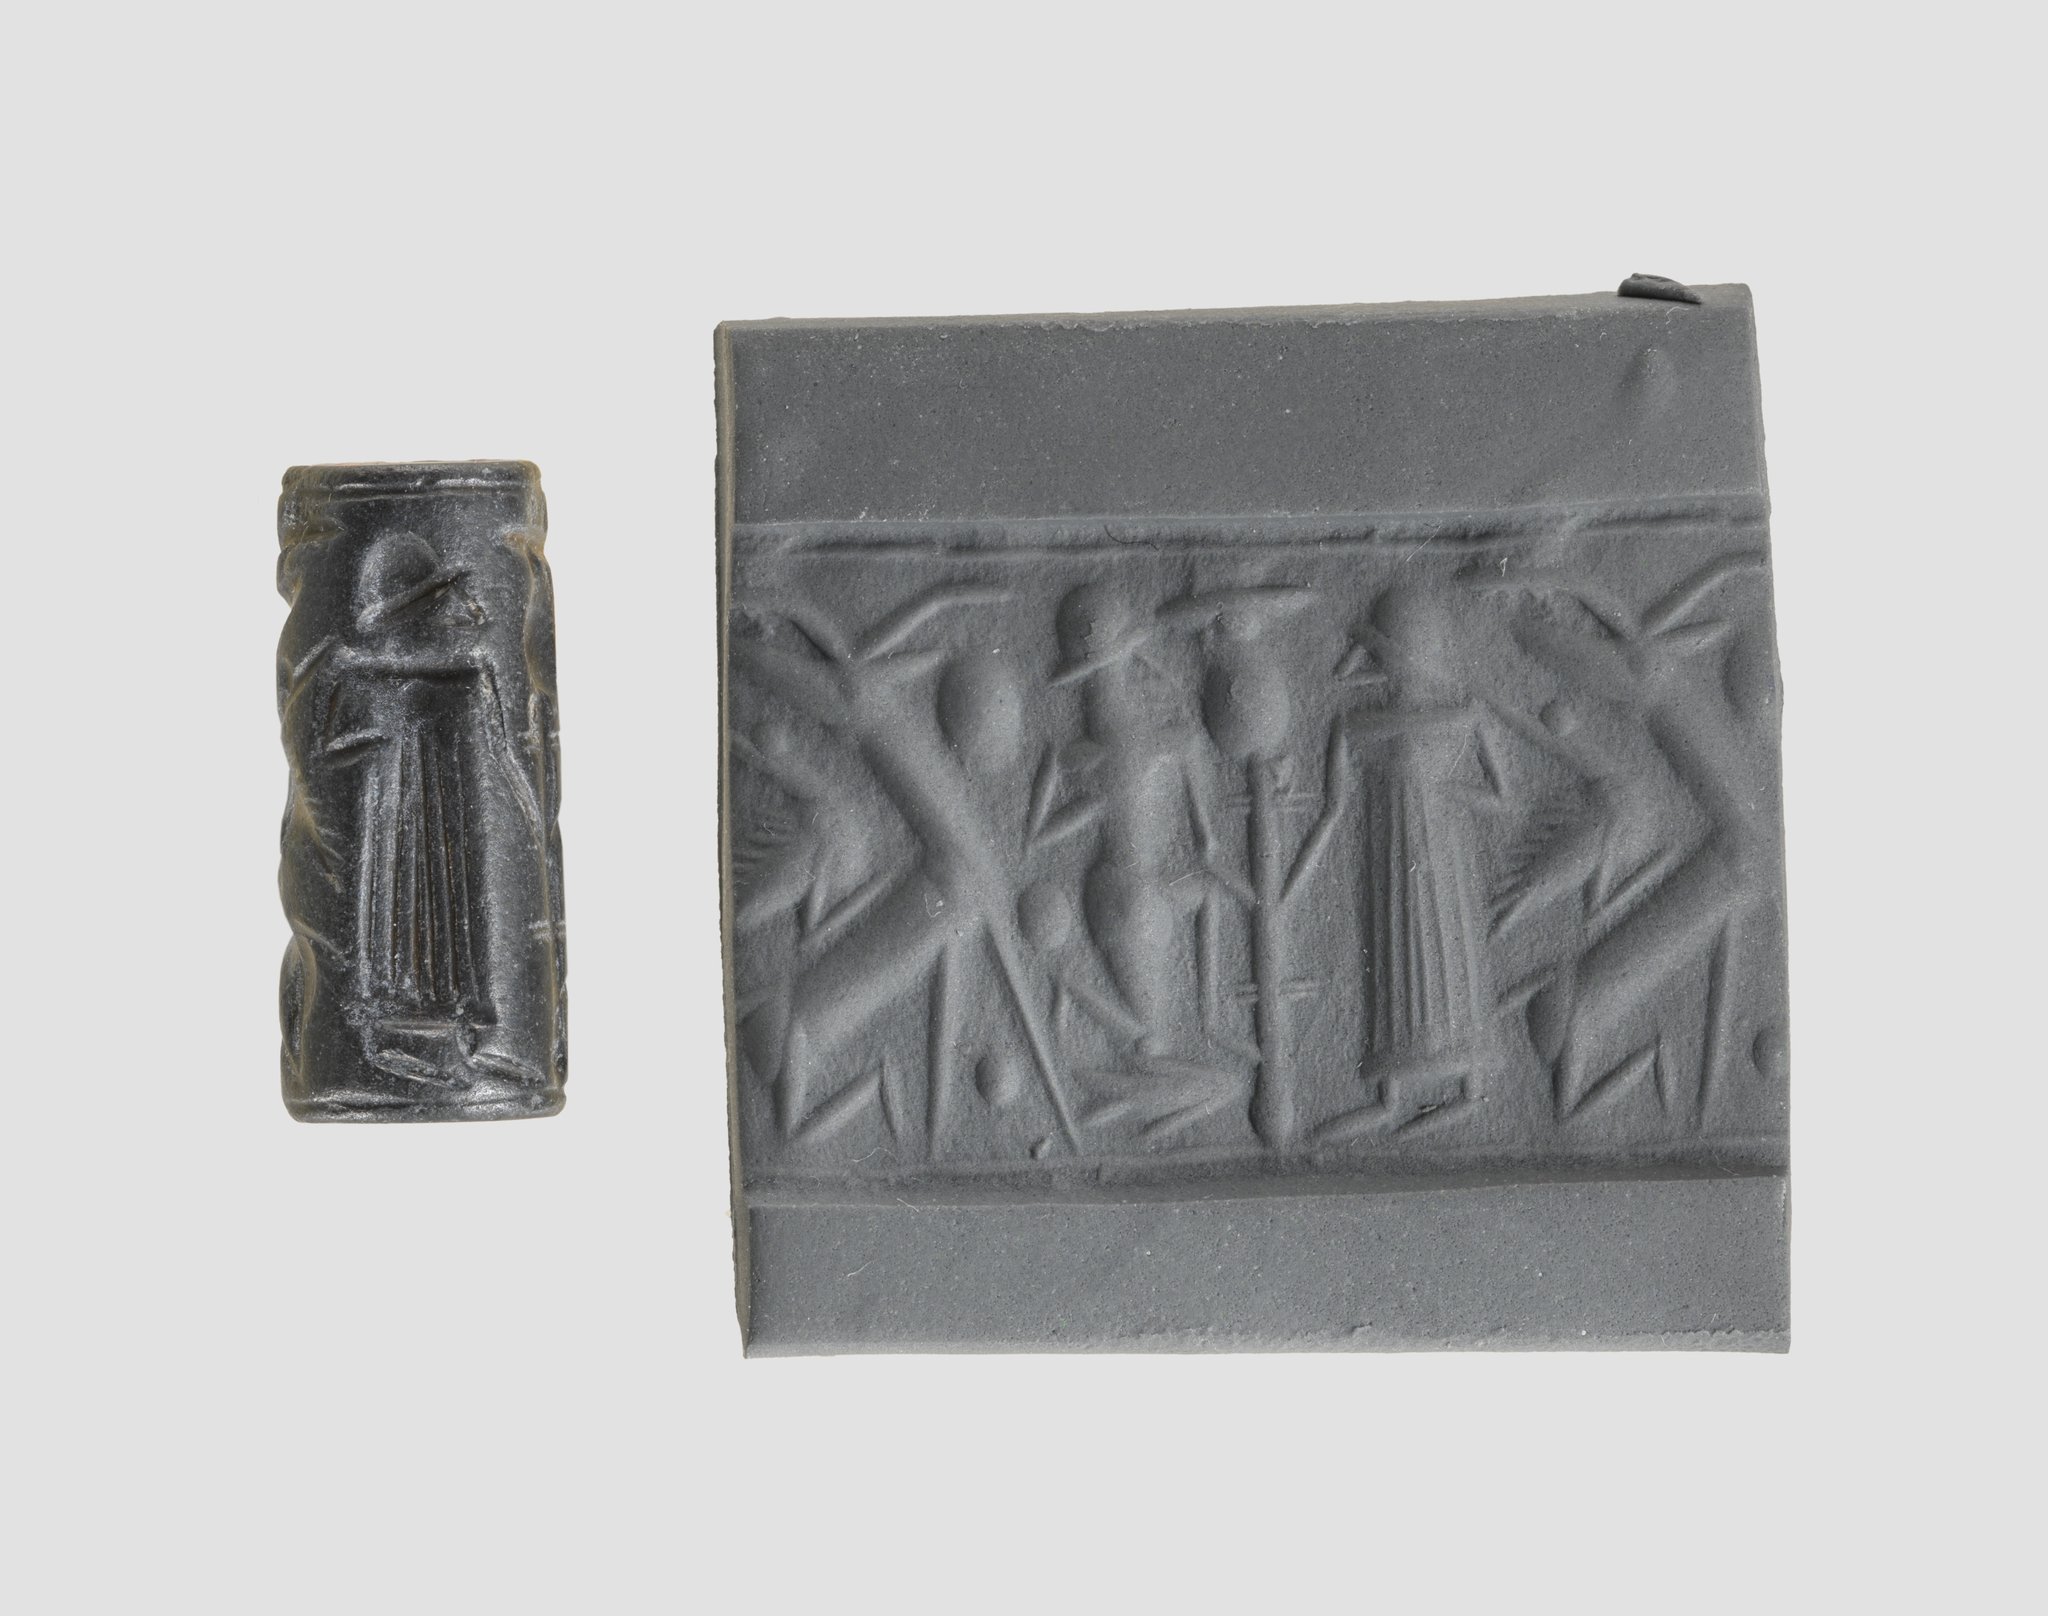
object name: cylinder seal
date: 1500-1100 BCE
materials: mineral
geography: syria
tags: women